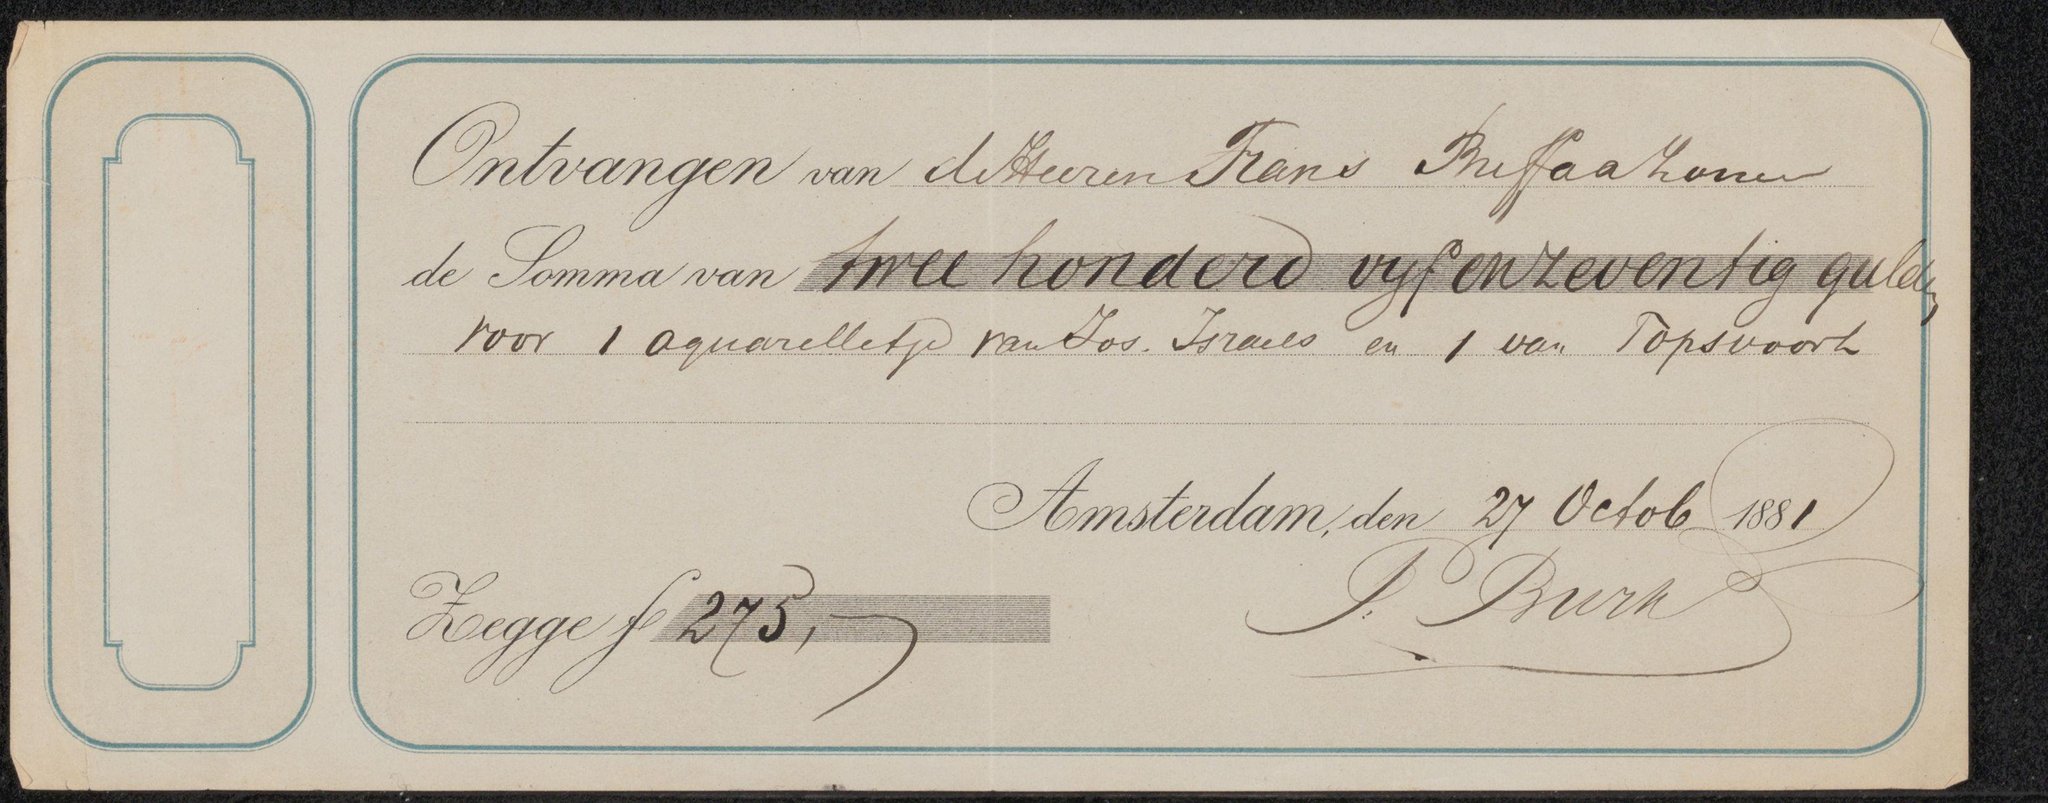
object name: ontvangstbewijs, kwitantie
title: Kwitantie voor P. Burk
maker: p. burk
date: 1881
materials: ink, paper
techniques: pen, printing, writing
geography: amsterdam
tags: the hague, painter, print maker, draughtsman, jozef israëls, drawing, money, amsterdam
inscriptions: collector's mark: Lugt 2233